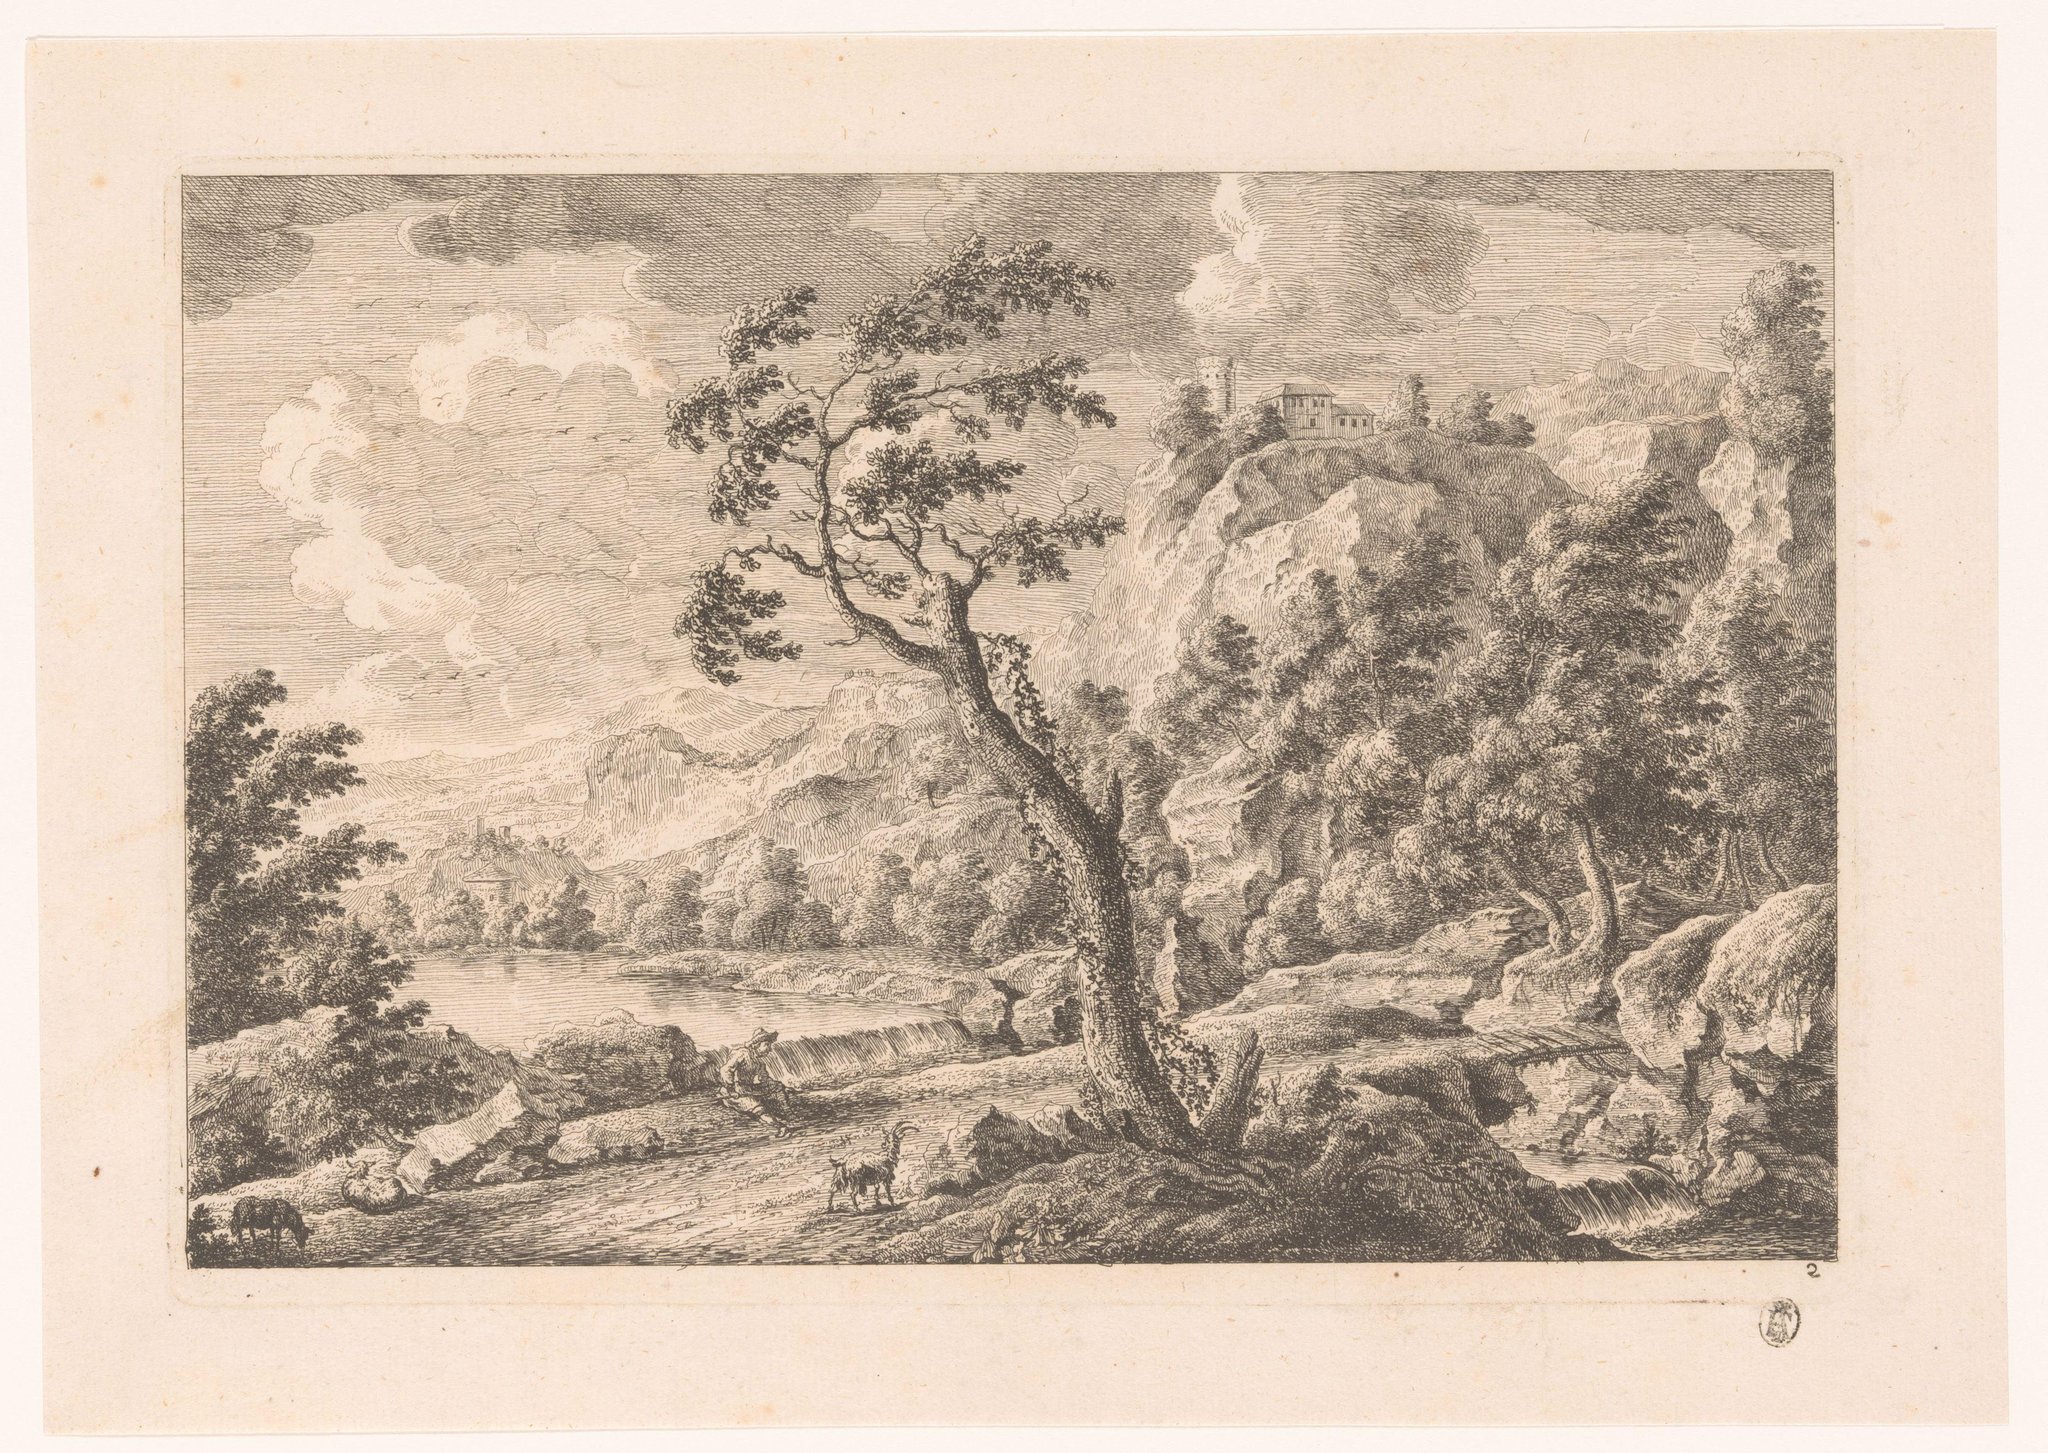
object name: print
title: Landschap met ruïne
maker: monogrammist meg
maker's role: print maker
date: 1700-1730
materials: paper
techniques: etching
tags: landscapes in the temperate zone, landscape with ruins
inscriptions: collector's mark: Lugt 2228, collector's mark: Lugt 2760, collector's mark: Lugt 971